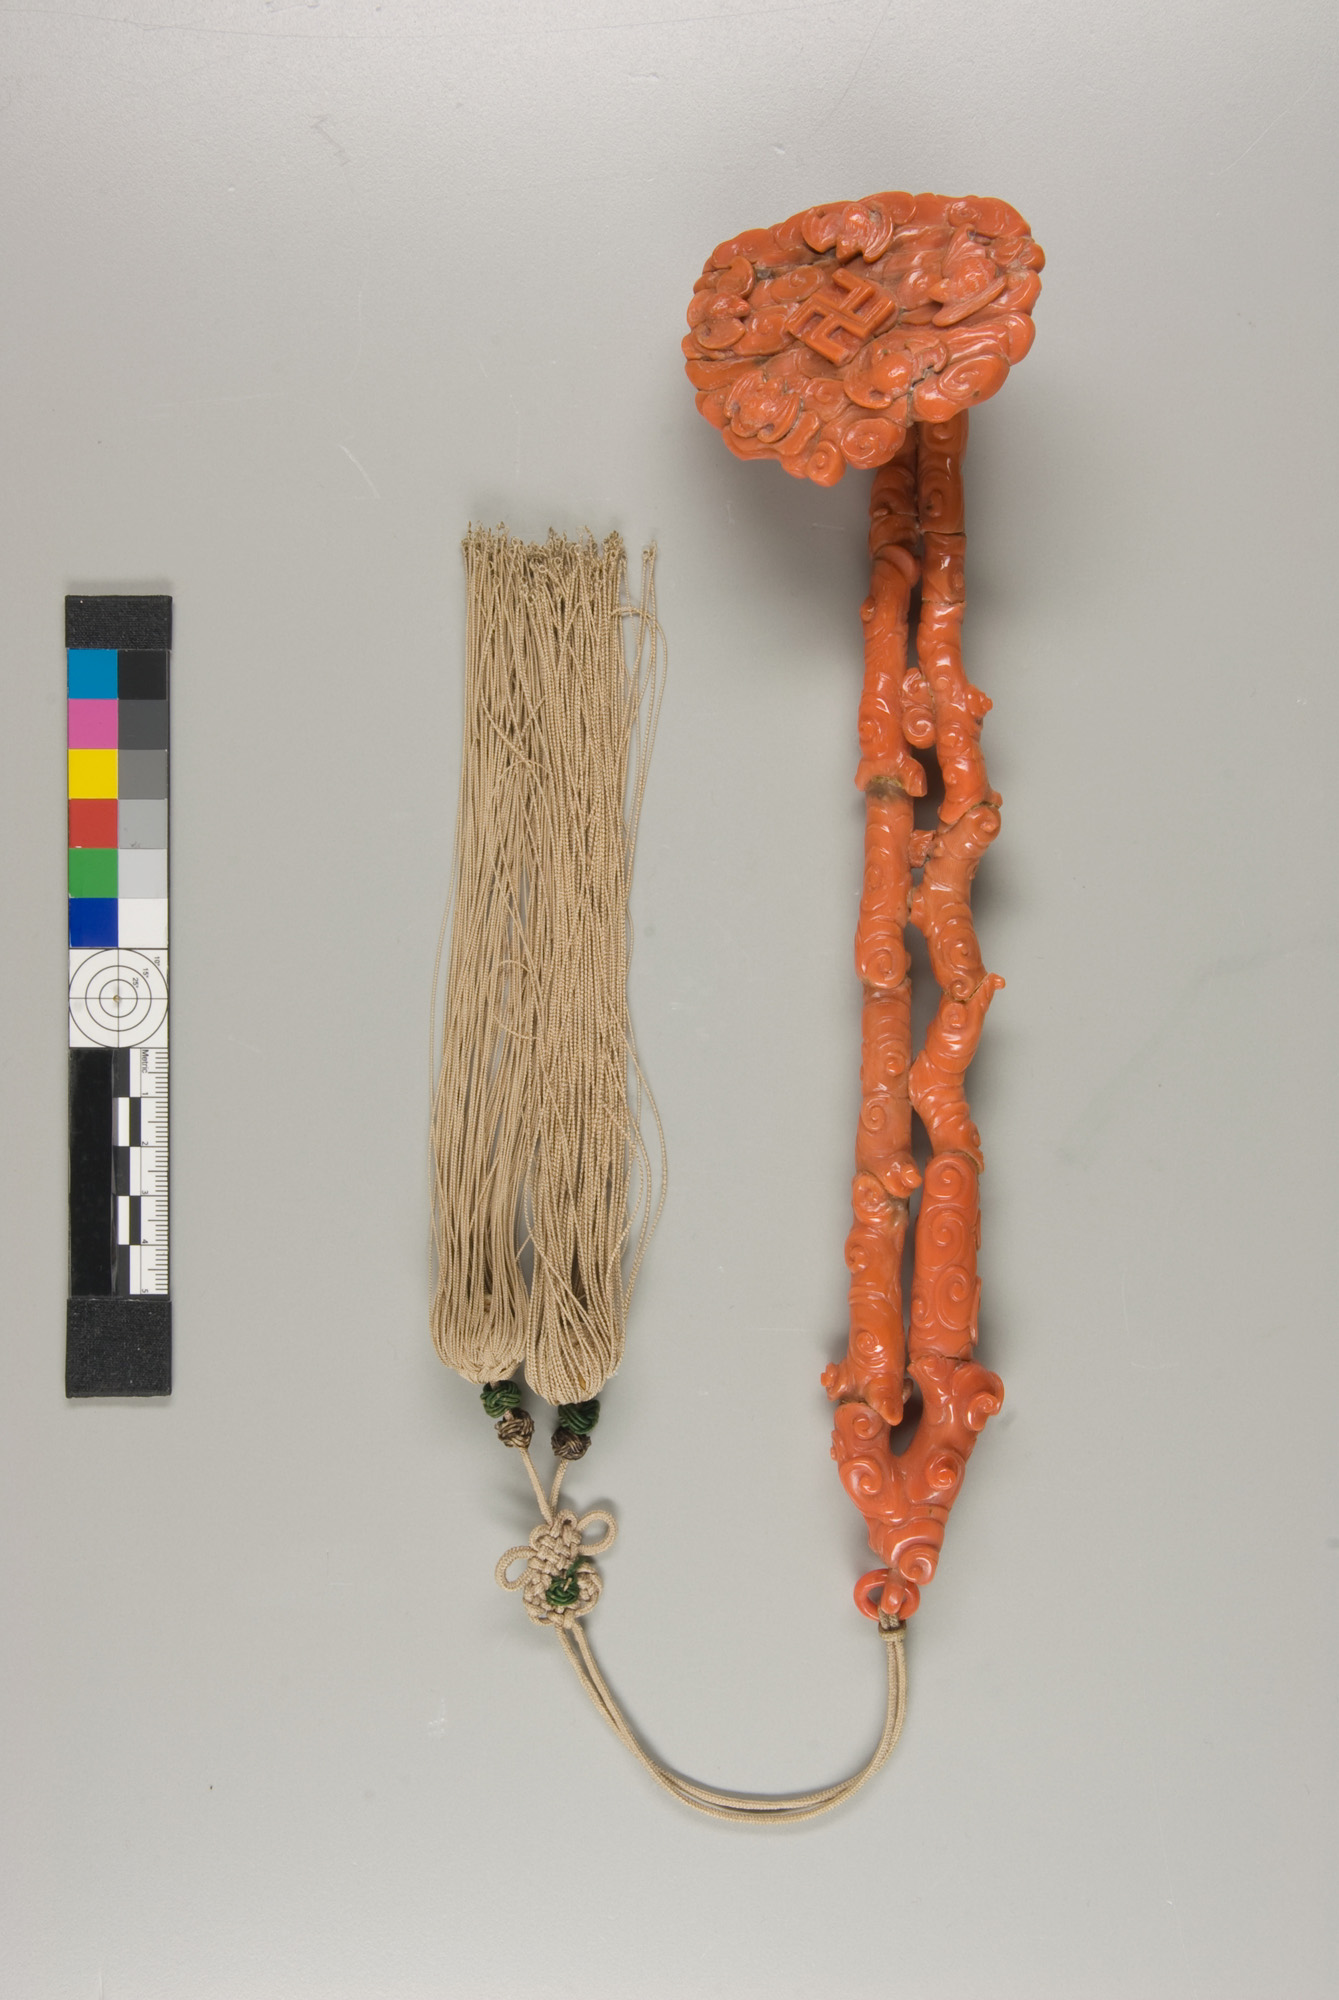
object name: sceptre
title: Ornament (ruyi)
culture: chinese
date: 1701-1800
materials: coral